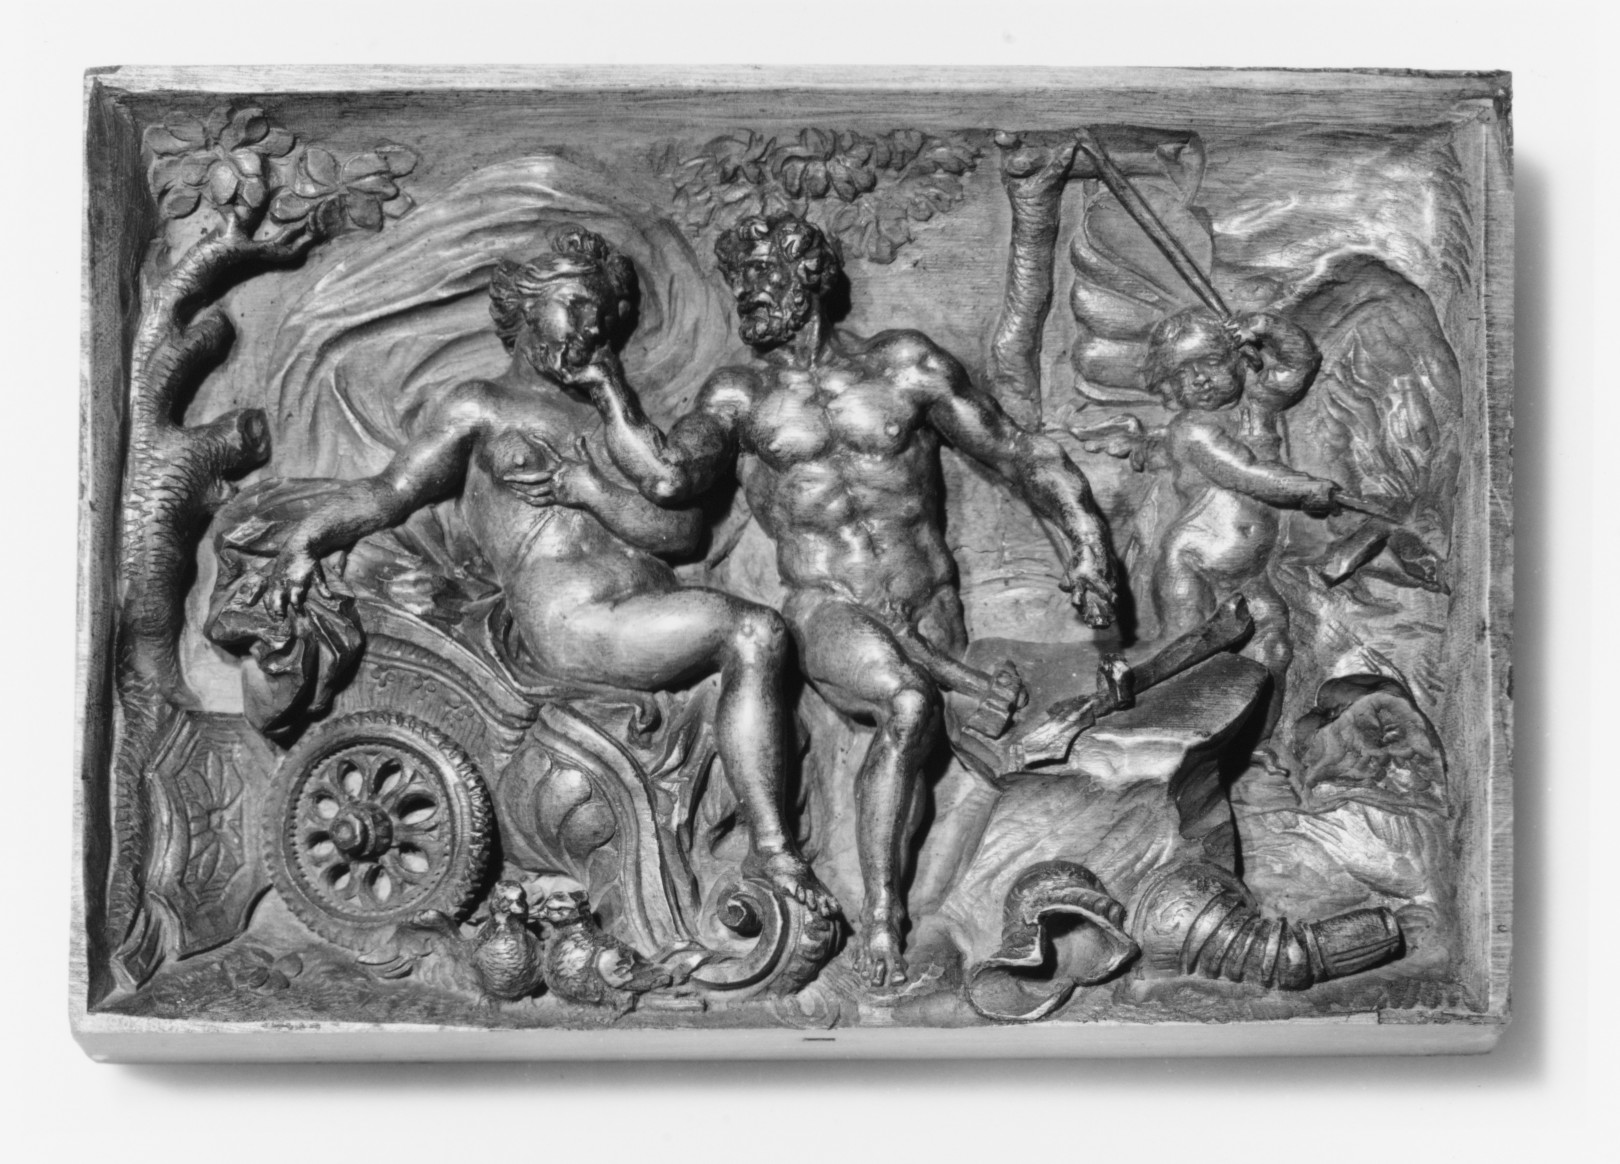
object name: high relief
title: Venus and Vulcan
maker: andrea brustolon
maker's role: artist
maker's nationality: italian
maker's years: 1662-1732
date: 1720-1730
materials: wood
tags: male nudes,female nudes,cupid,venus,vulcan